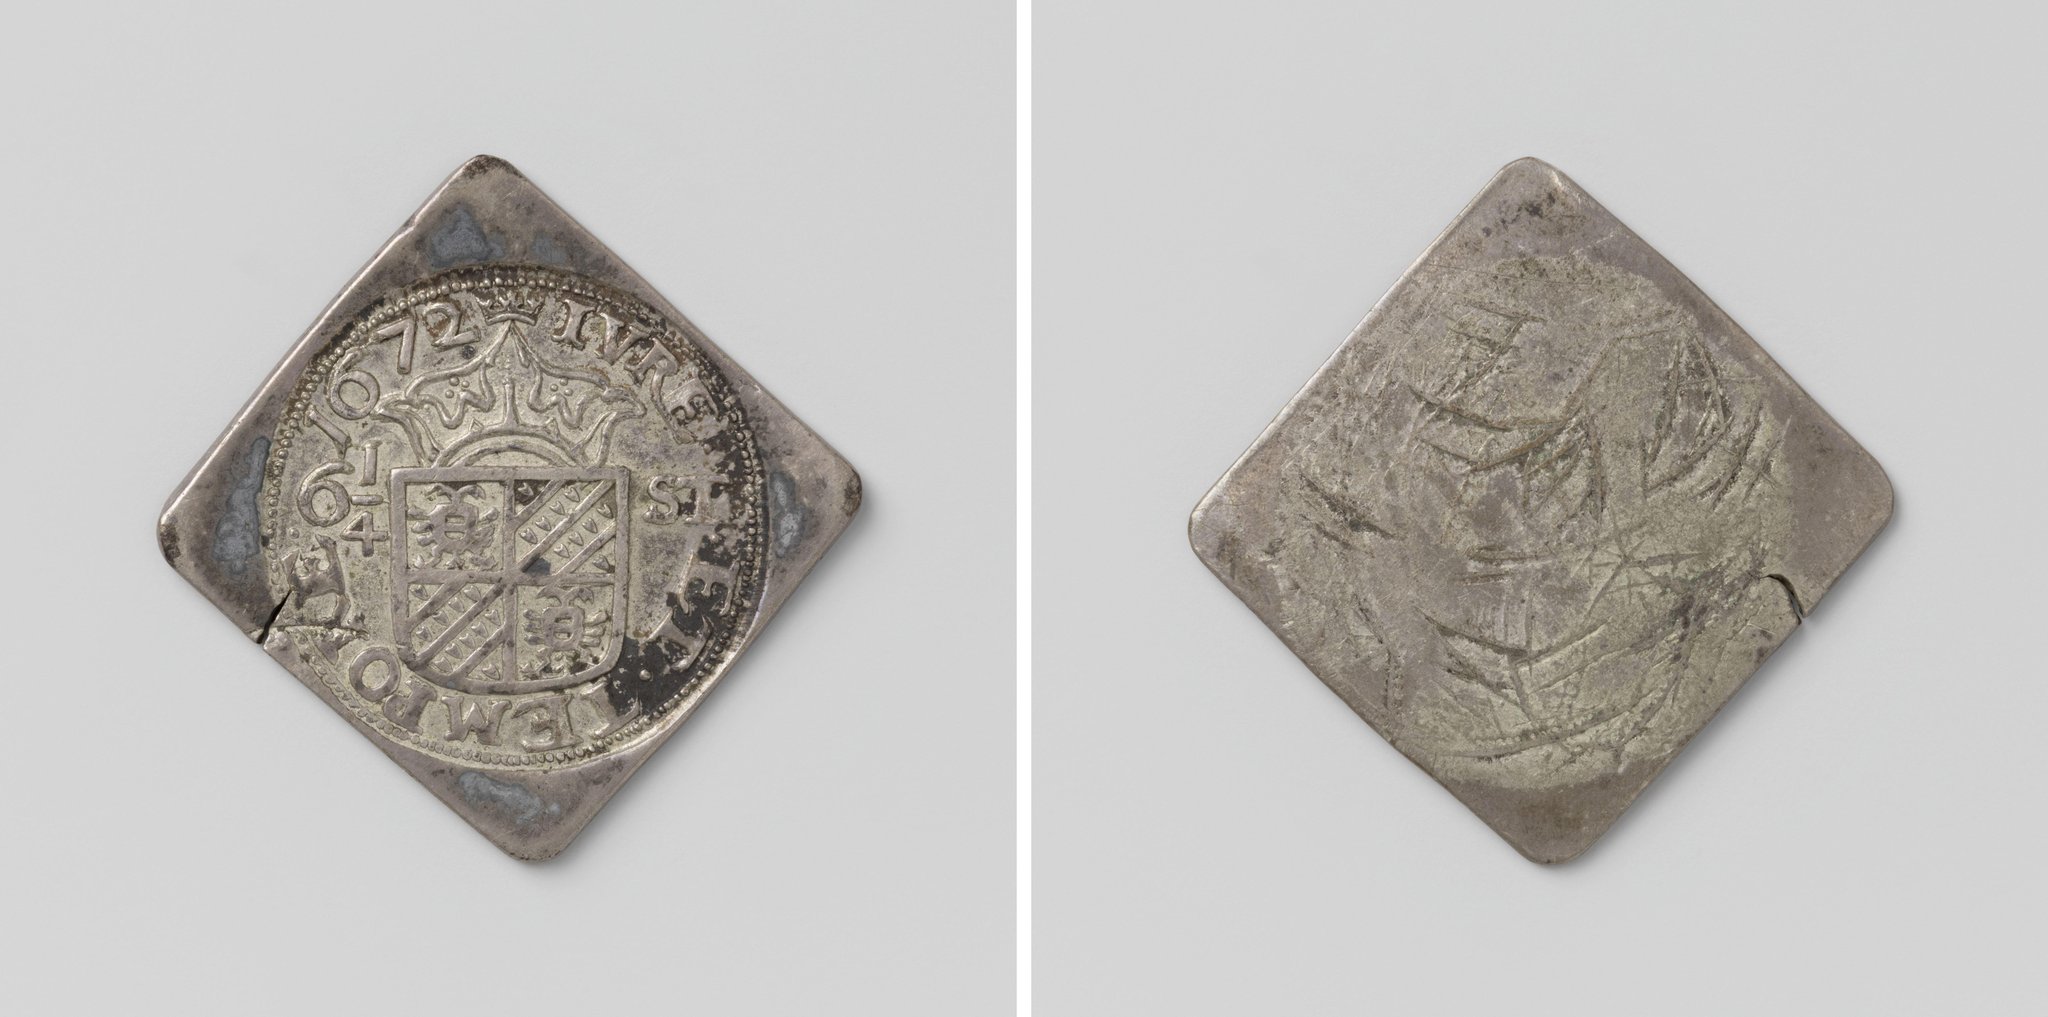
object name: siege coin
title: Achtste daalder, noodmunt uit Groningen, geslagen tijdens het beleg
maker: Anonymous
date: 1672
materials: silver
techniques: striking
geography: groningen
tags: groningen, beleg van groningen (1672)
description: Achtste daalder van Groningen. eenzijdige, ruitvormige noodmunt met afgeronde hoeken, links onder ingescheurd. Voorzijde: gekroond wapenschild tussen waardeaanduiding binnen omschrift. Keerzijde: blanco